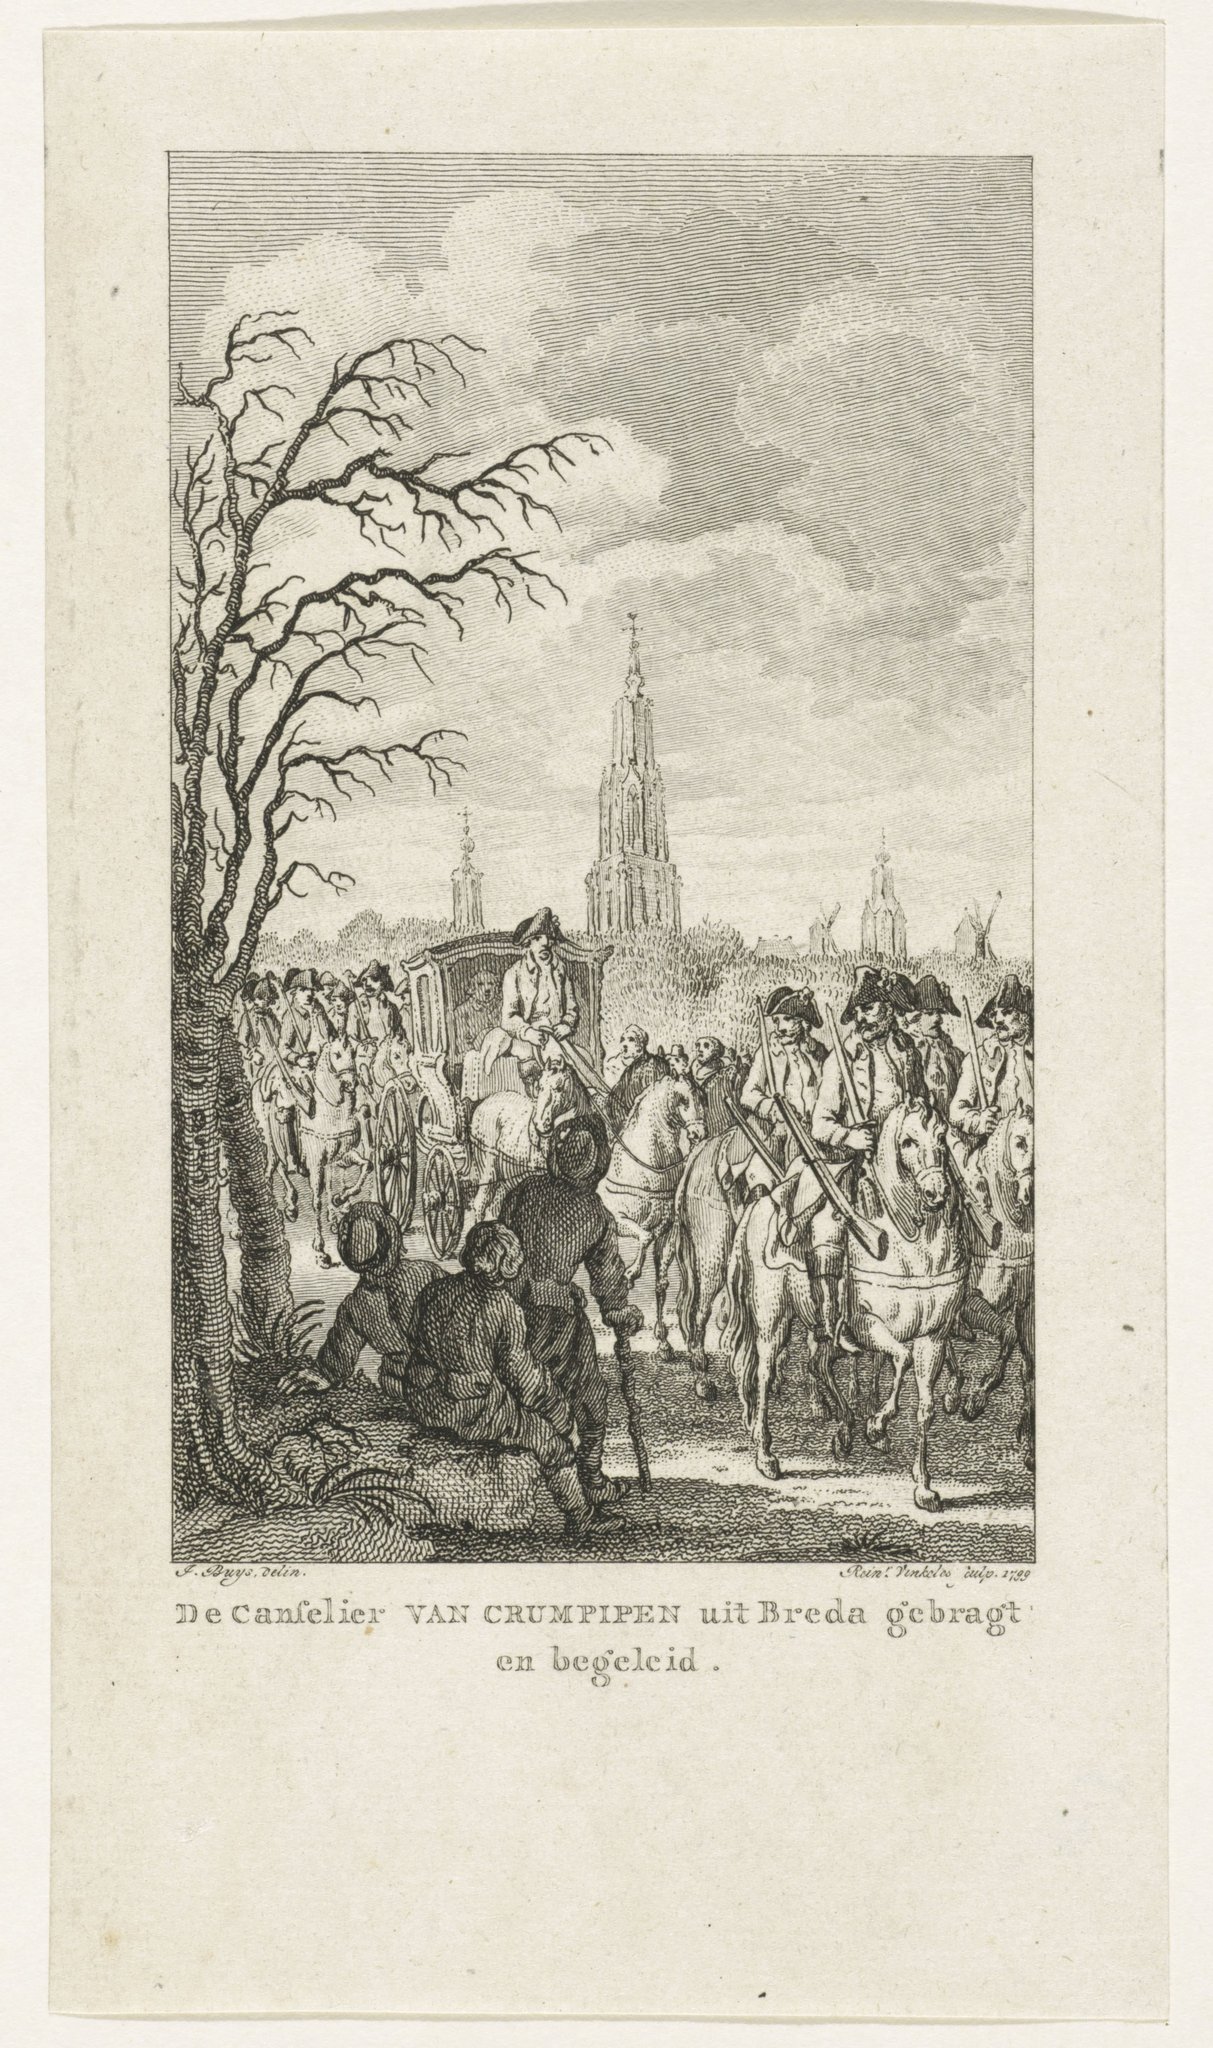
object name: print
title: De Canselier Van Crumpipen uit Breda gebragt en begeleid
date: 1799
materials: paper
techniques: engraving, etching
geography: northern netherlands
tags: brussels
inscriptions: collector's mark: Lugt 2228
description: Gebruikt als illustratie in: P.A. Loosjes. Vaderlandsche historie, vervattende de geschiedenissen, der Vereenigde Nederlanden (...). Ten onmiddelyken vervolge van Wagenaar's Vaderlandsche historie. Amsterdam: Johannes Allart, dl. 22 (1799).